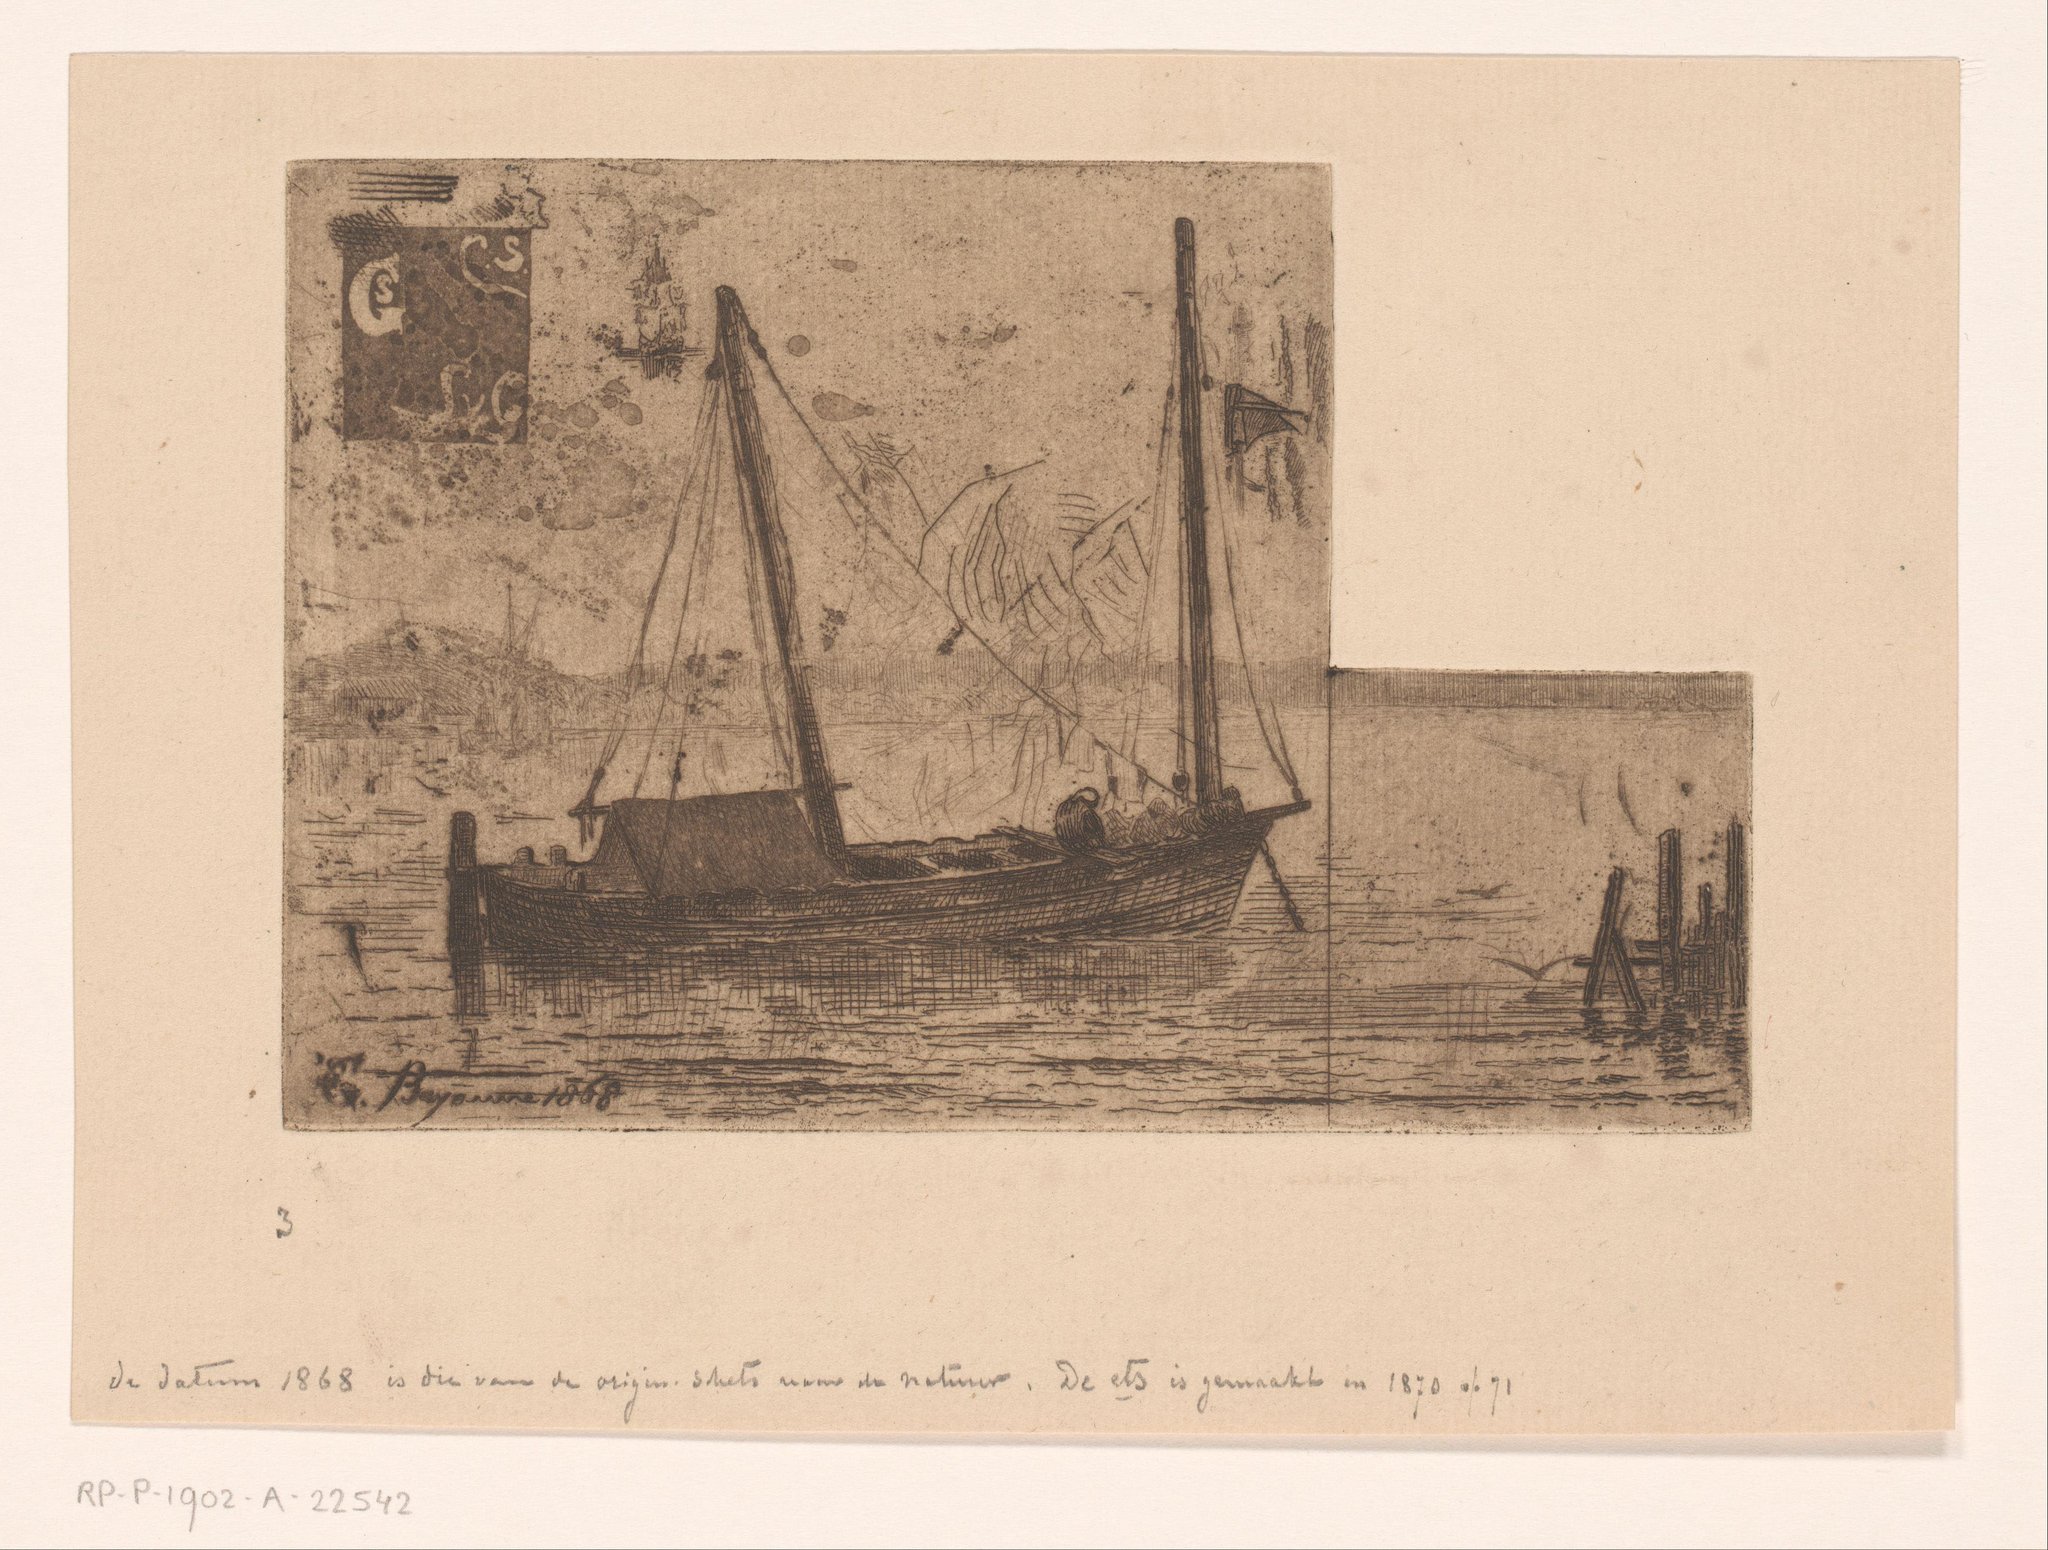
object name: print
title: Une lancha sur l'Adour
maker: carel nicolaas storm van s-gravesande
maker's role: draughtsman, print maker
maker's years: 1841-1924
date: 1870-1871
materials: paper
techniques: etching, intaglio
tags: sailing-ship, sailing-boat, river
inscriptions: collector's mark: Lugt 2228, inscription: ‘De datum 1868 is die van de origin. schets naar de natuur. De ets is gemaakt in 1870 of 71’